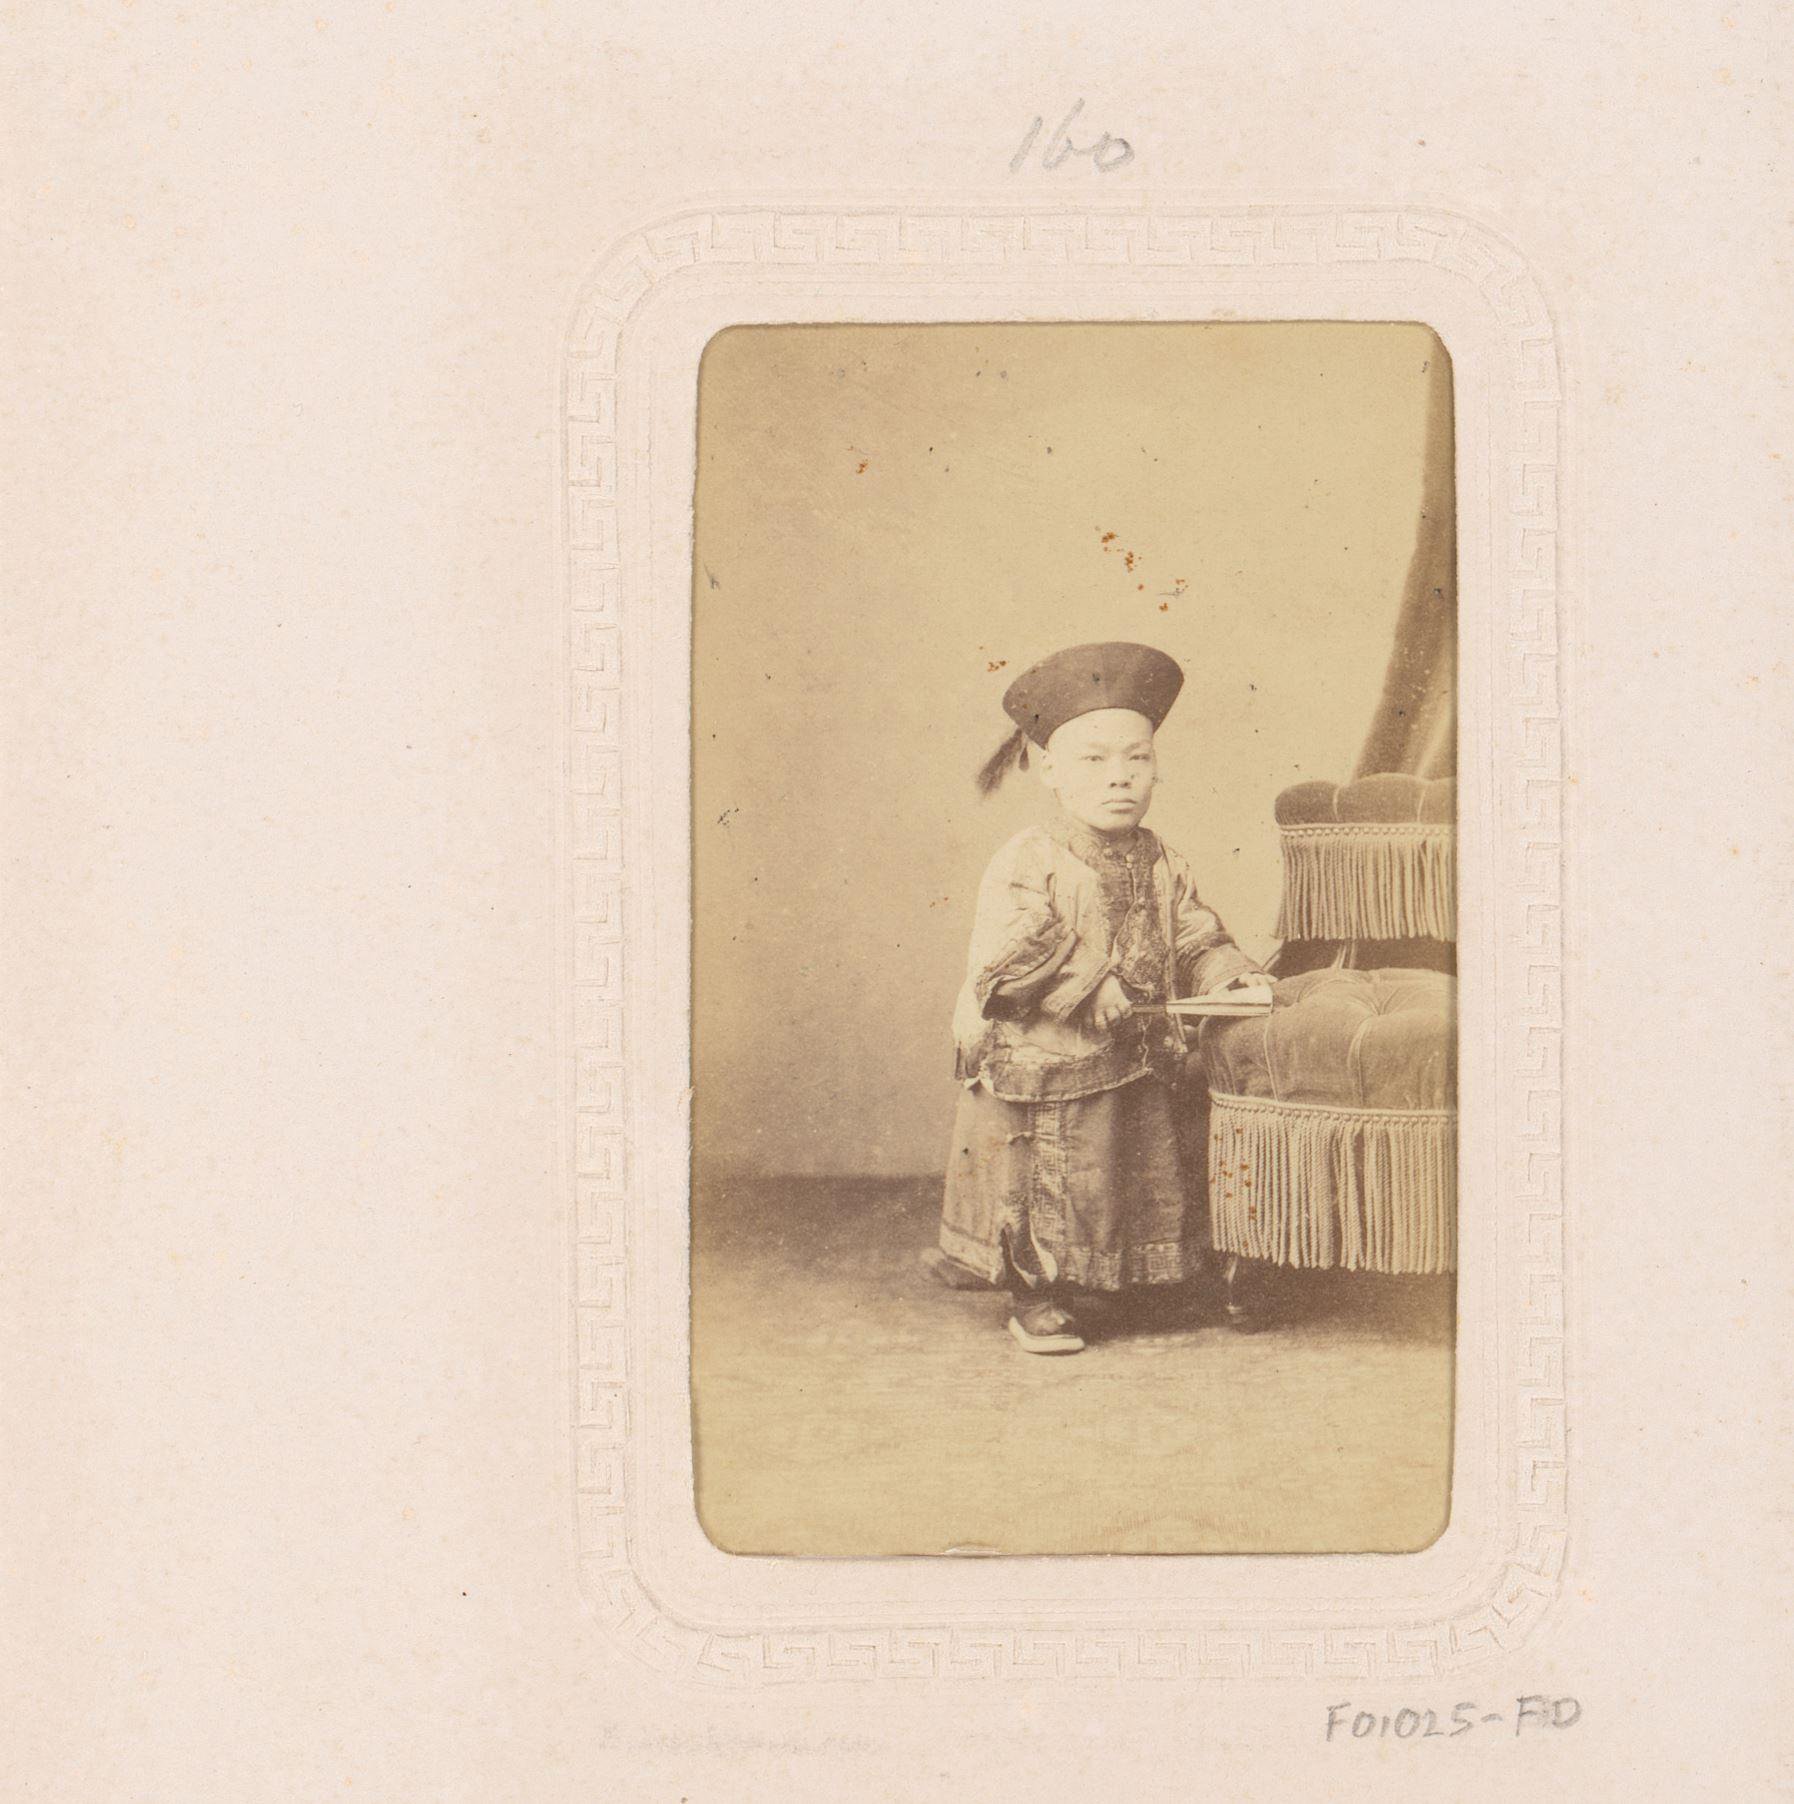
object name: carte de visite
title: Portret van een man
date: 1850-1880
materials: cardboard, photographic support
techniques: albumen print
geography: paris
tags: little people, historical persons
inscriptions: inscription: ‘Photographie Maujean et Léopold Dubois/ 30, Rue du Faubourg St. Honore (...) Paris’, number: ‘160’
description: Portret van een man met dwerggroei. Deze foto maakt deel uit van een album.